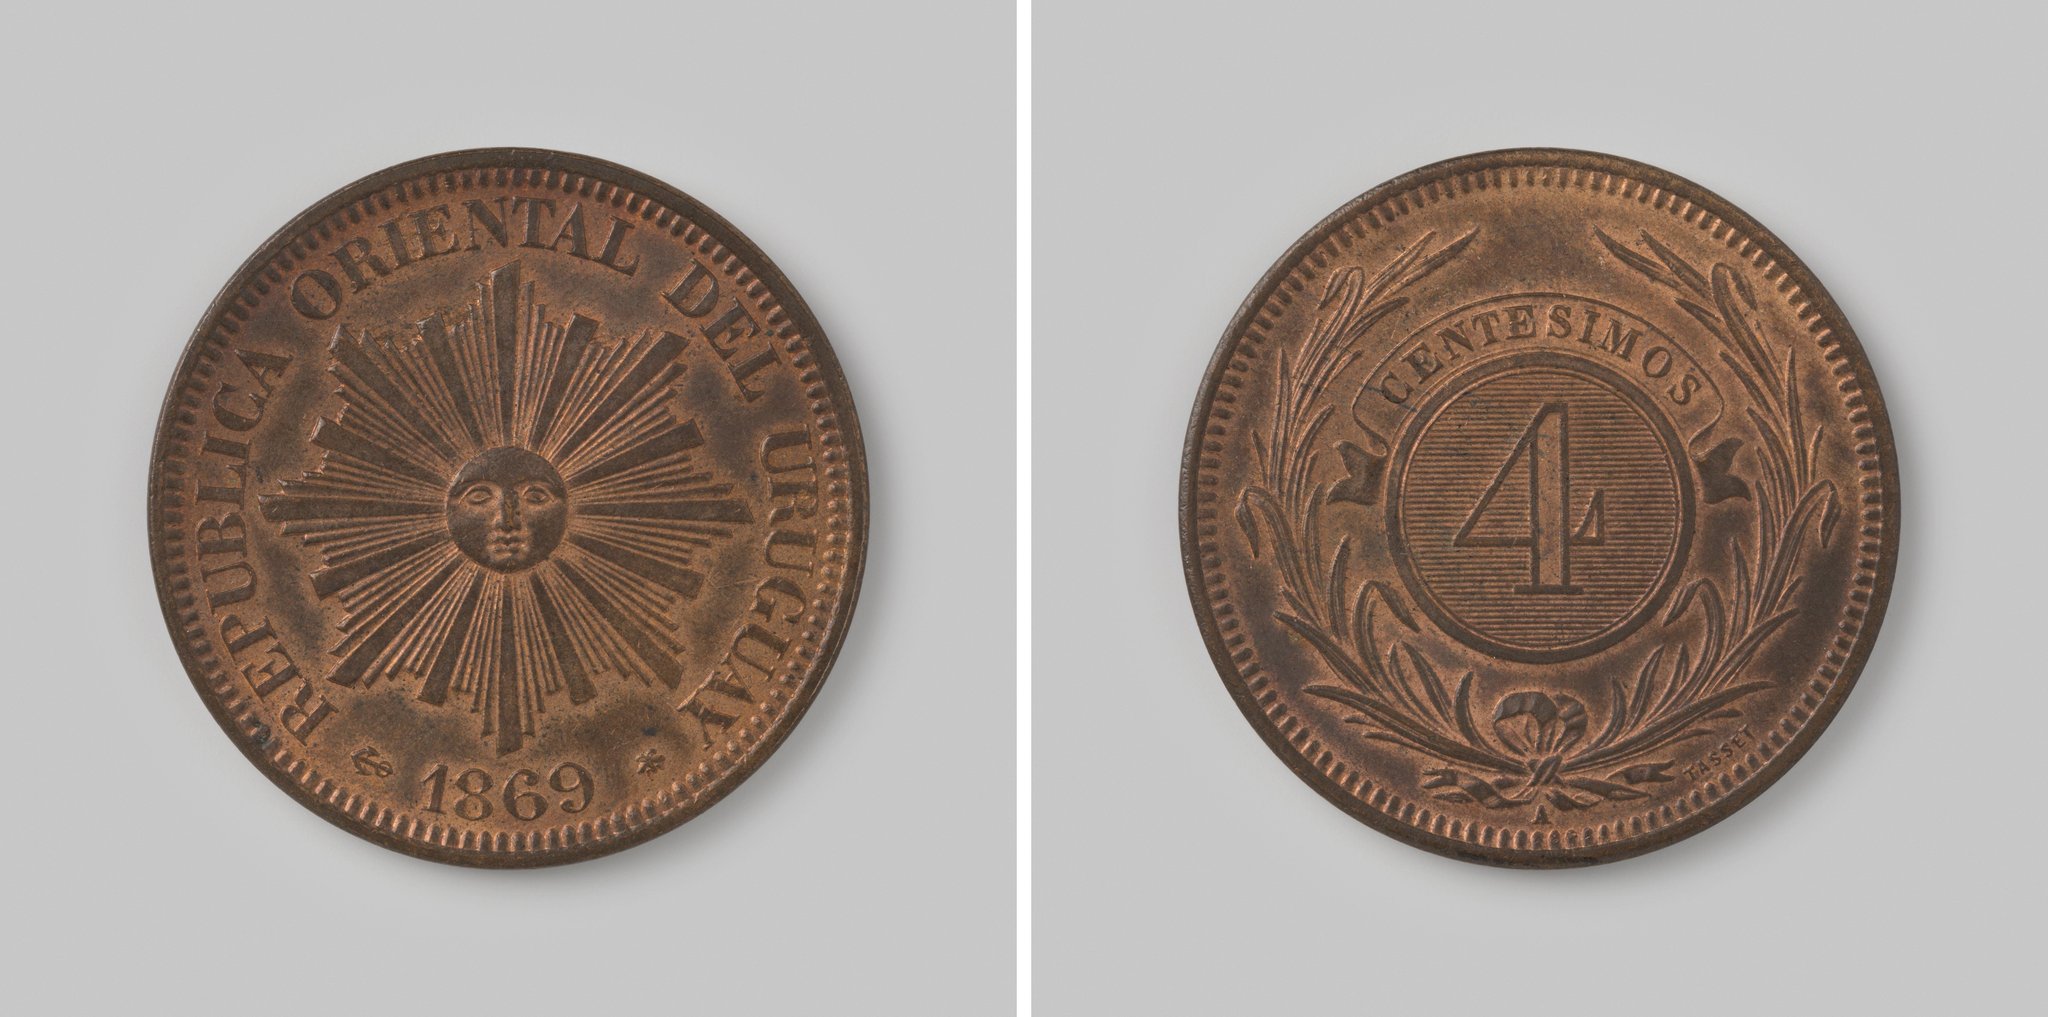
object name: coin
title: 4 centesimos uit Uruguay, 1869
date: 1869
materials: copper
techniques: striking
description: Koperen munt. Voorzijde: door grote en kleine stralen omgeven zon, waarin mensengezicht. Jaartal onderaan. Keerzijde: tussen twee samengebonden takken in twee regels waarde-aanduiding: centesimos 4 in twee regels. Gladde rand.